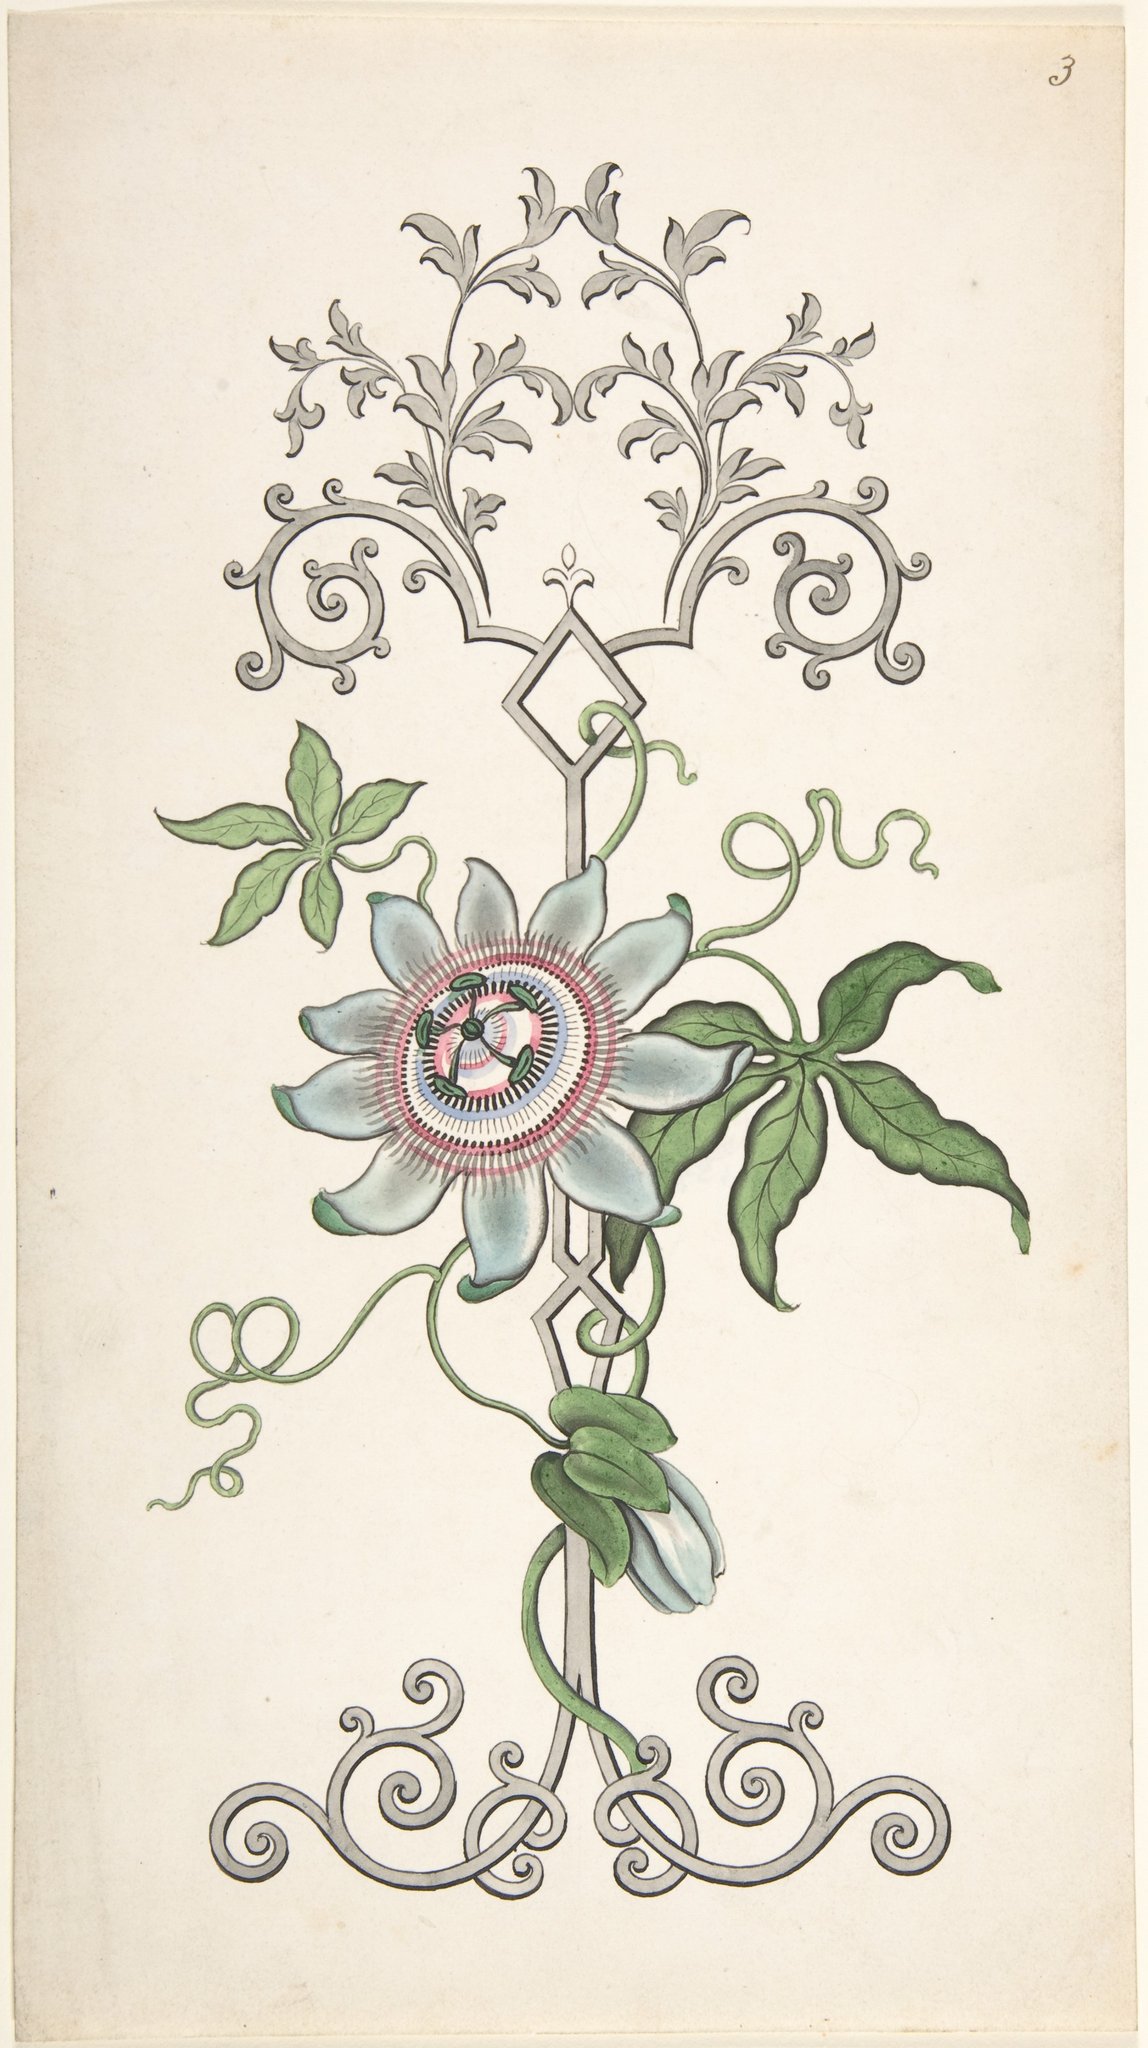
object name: drawing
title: Design for Panel Decoration Centered on a Passion Flower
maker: j. hulme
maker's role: artist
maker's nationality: british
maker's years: 1800-1880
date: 1828-1840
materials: ink, watercolor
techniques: pen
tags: flowers,leaves